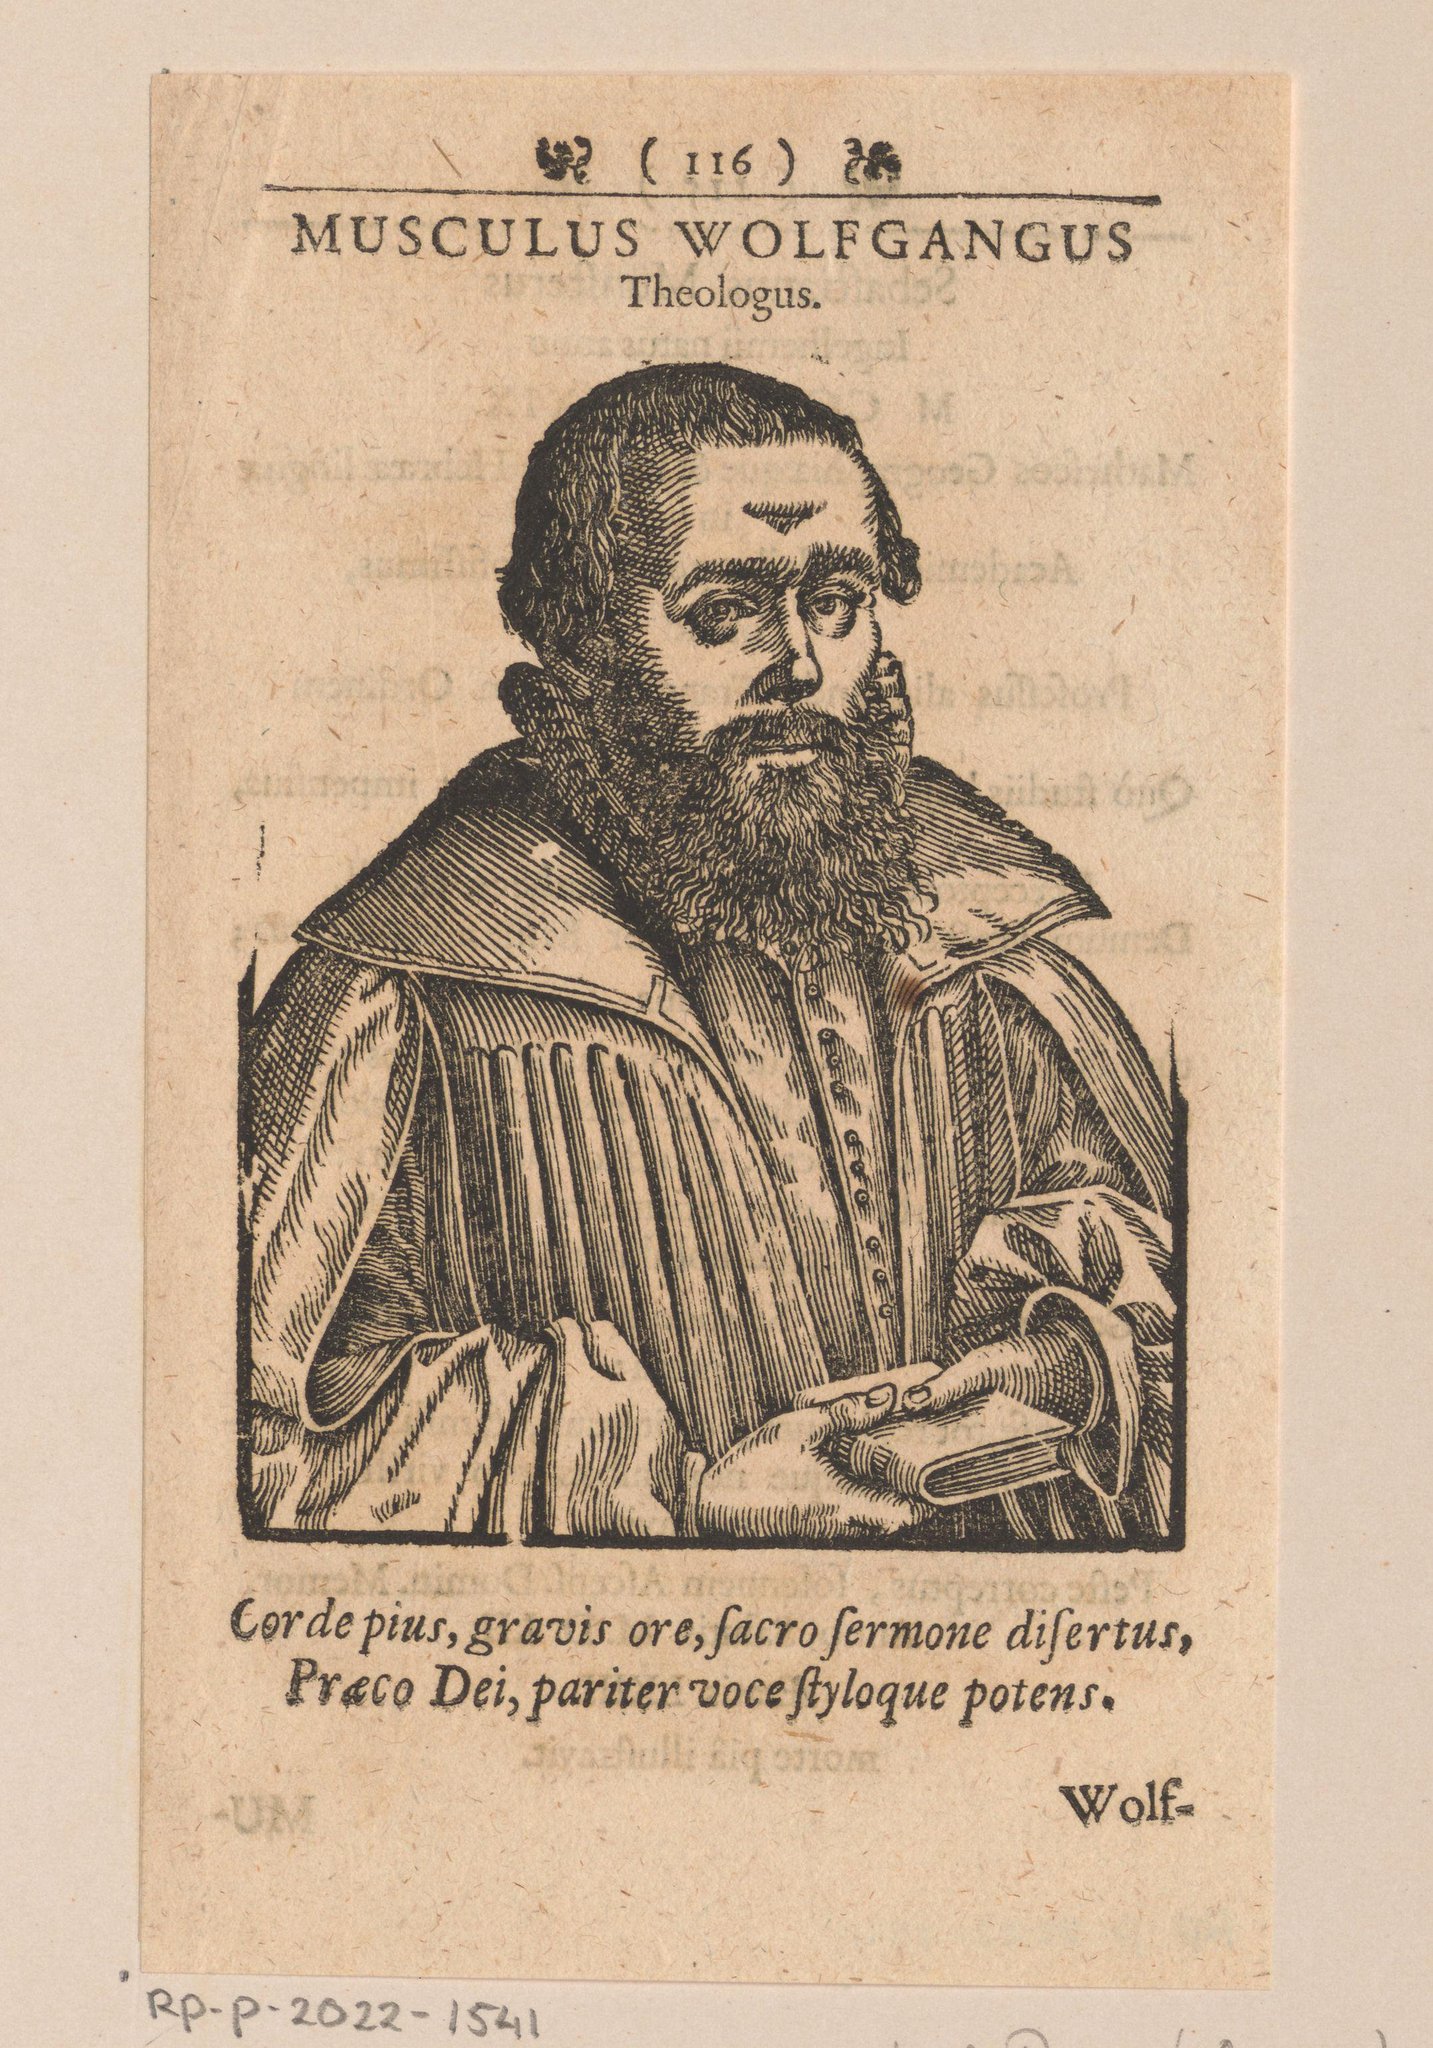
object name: print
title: Musculus Wolfgangus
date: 1720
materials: paper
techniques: letterpress printing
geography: frankfurt am main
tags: theologian, historical persons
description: Prent uit: Reusner, Nicolaus en Tobias Stimmer. Icones sive imagines virorum literis illustrium qui seculo XV. (...) Frankfurt am Main: Johann Balthasar Diehl, 1720, p. 116.